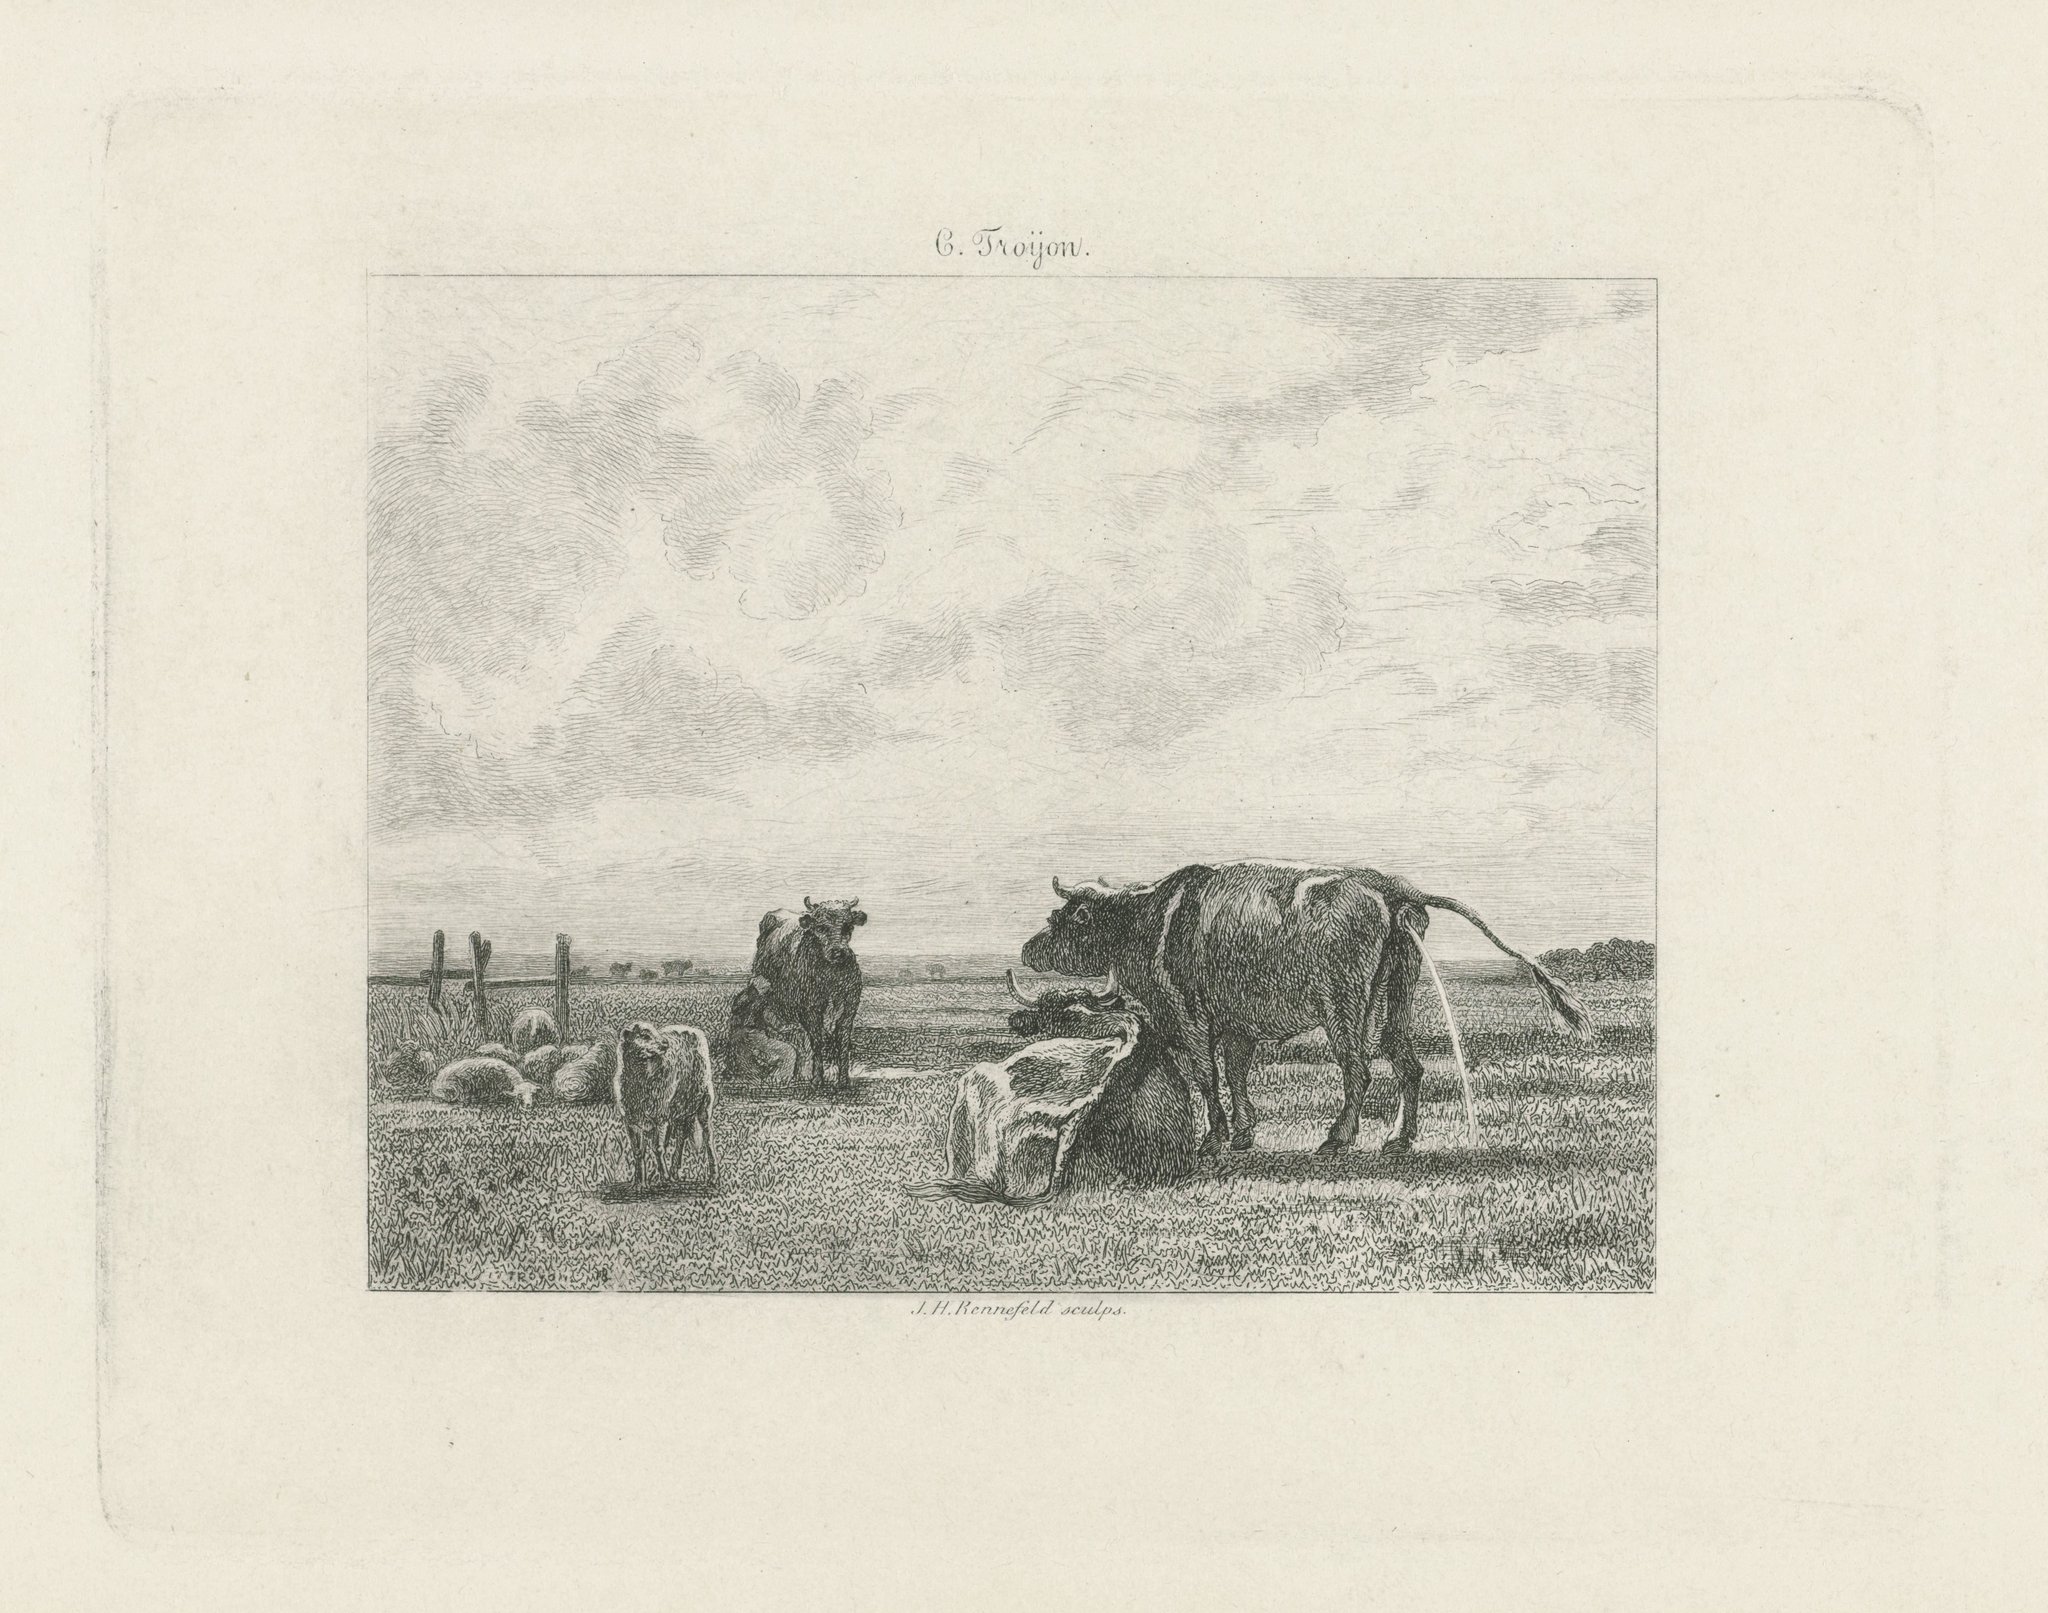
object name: print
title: Landschap met koeien en schapen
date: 1842-1877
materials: paper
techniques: engraving, etching, roulette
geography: amsterdam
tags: cow, sheep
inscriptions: collector's mark: Lugt 2228